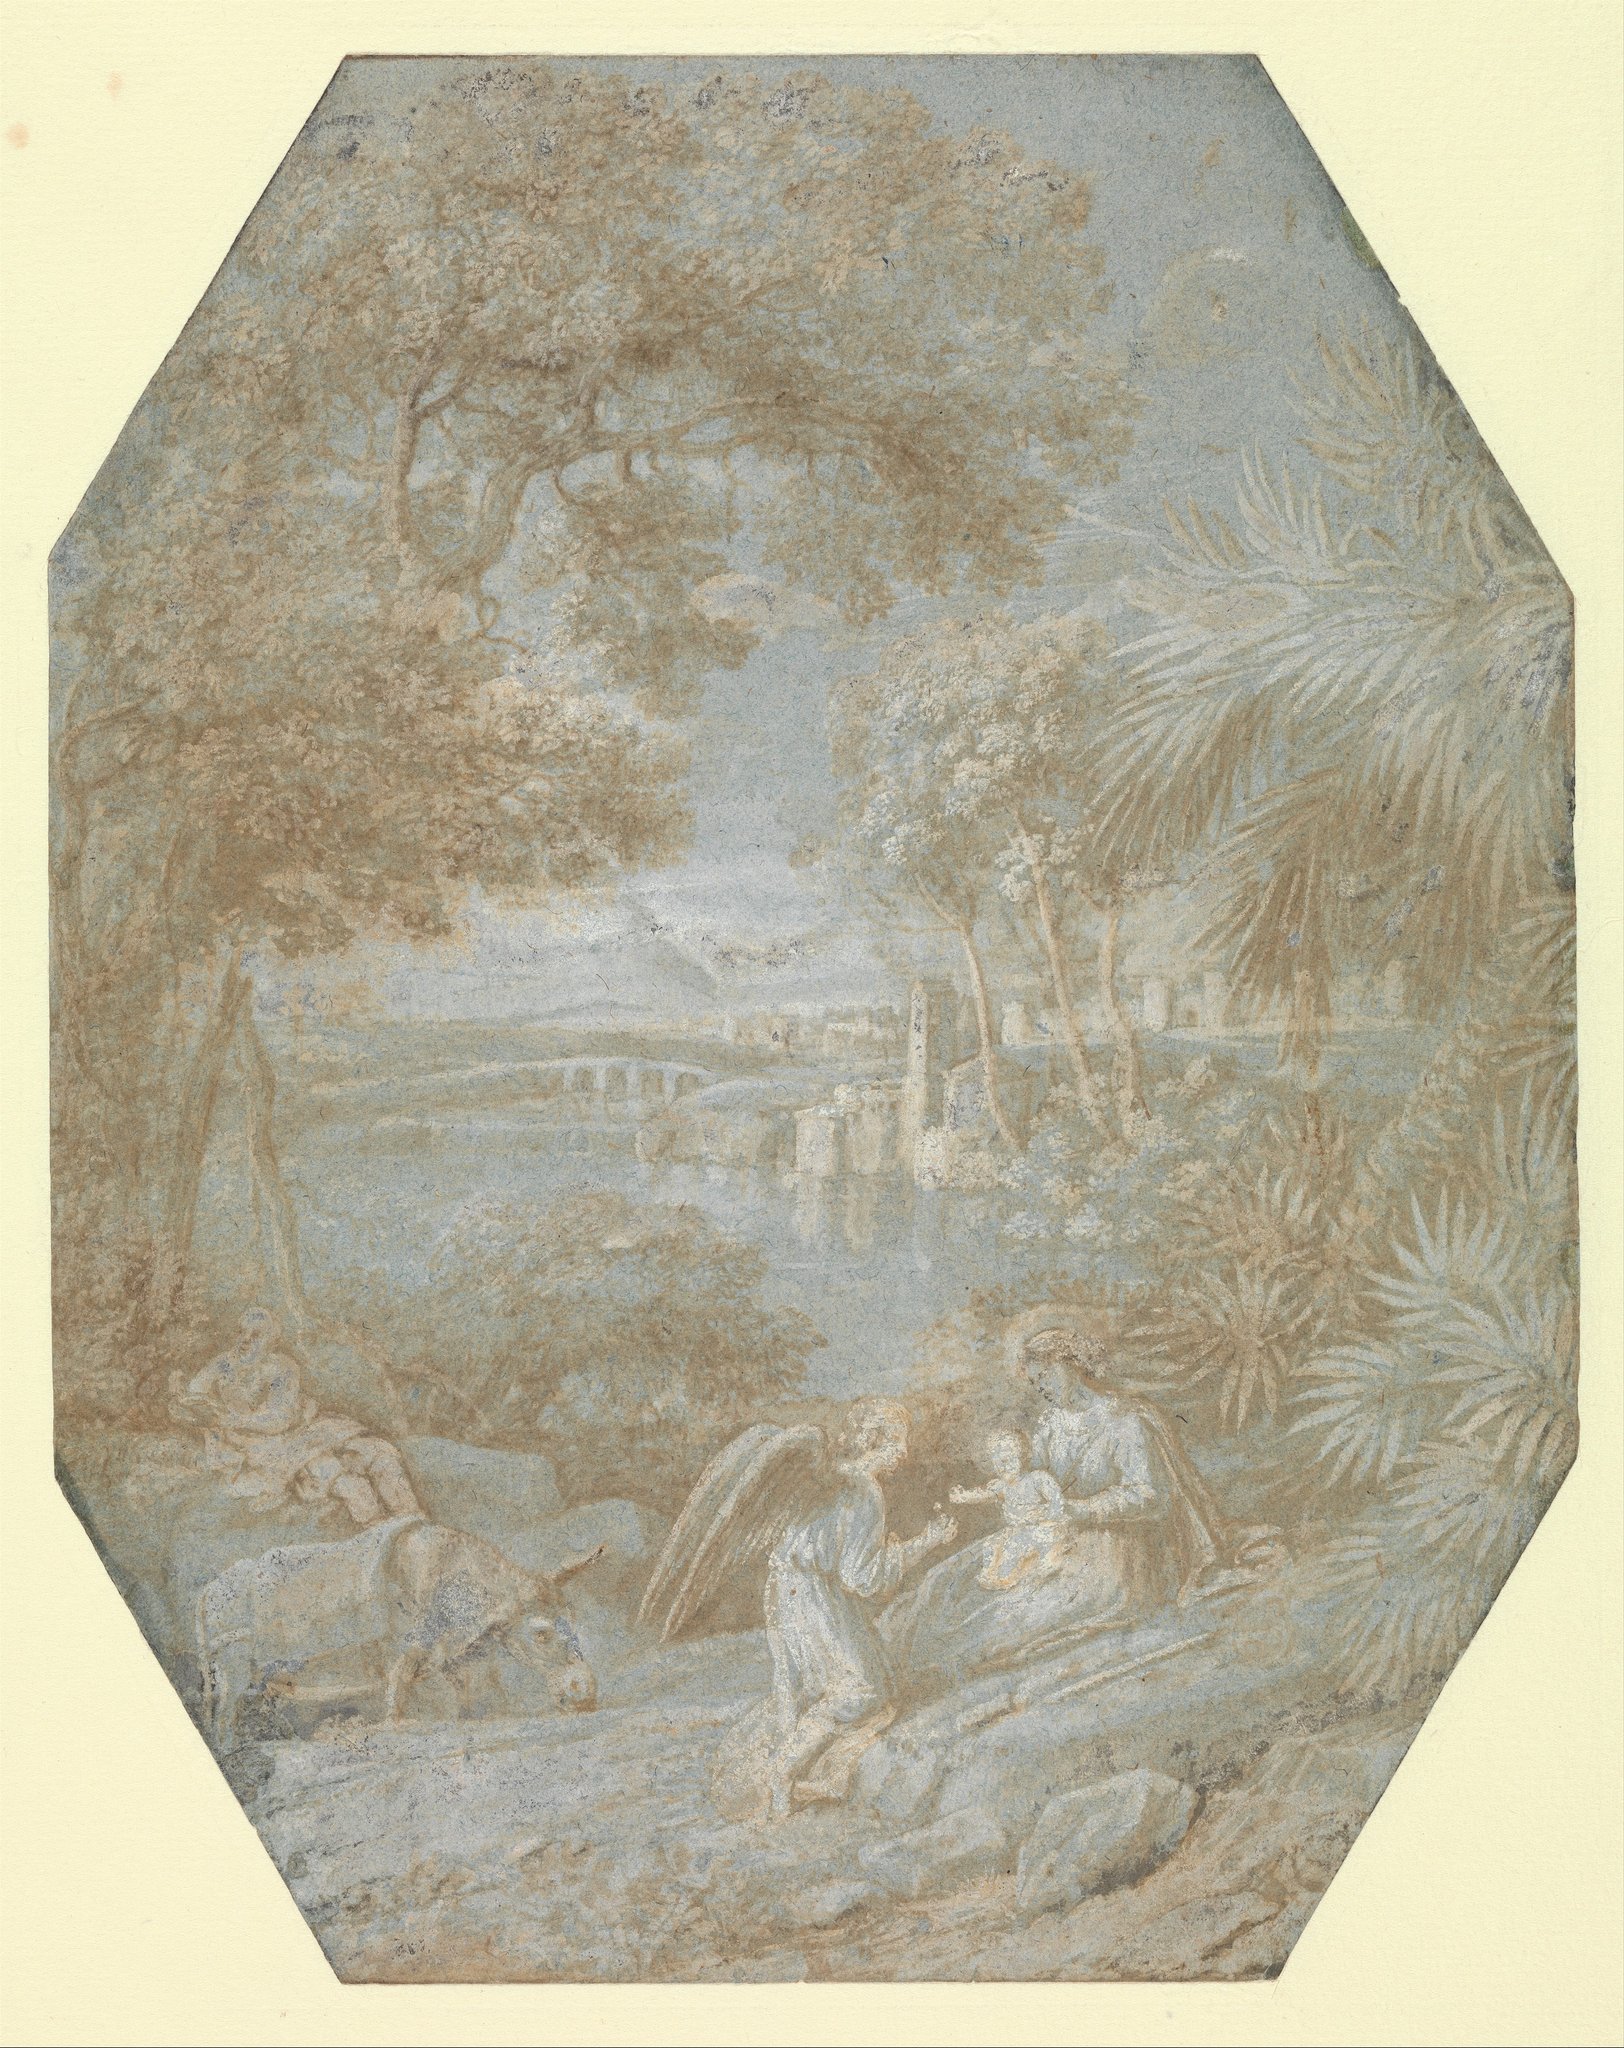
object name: drawing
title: Landscape with the Rest on the Flight into Egypt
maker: claude lorrain (claude gellée)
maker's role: artist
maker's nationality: french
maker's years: 1604-1682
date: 1645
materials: gouache, paper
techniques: heightening, wash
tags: landscapes,angels,virgin mary,jesus